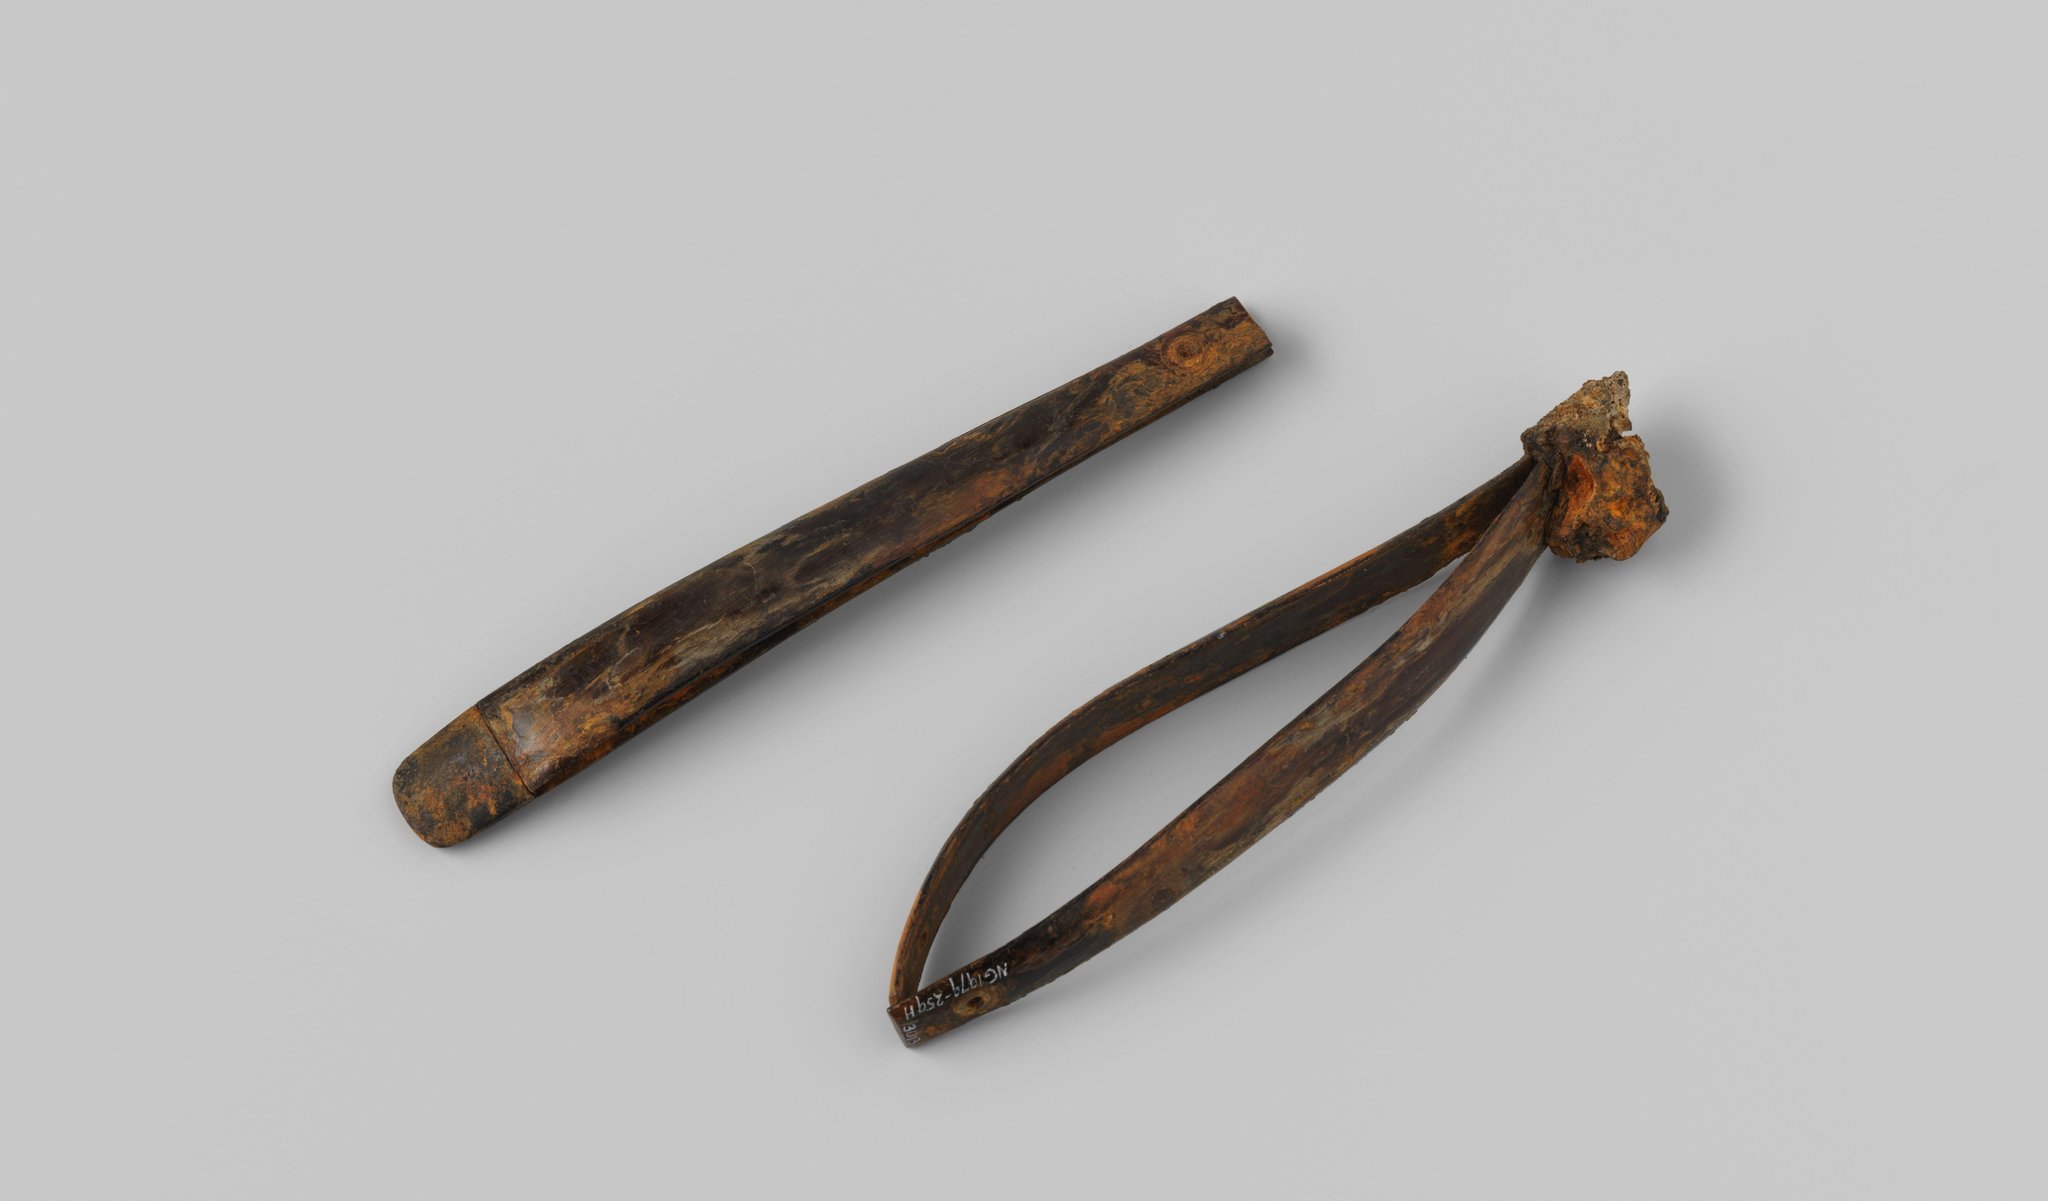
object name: scheermes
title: Razor from the wreck of the Dutch East Indiaman Hollandia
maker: Anonymous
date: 1700-1743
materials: bone, shell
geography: netherlands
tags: verenigde oostindische compagnie, hollandia (schip), annet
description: Razor, handle; each consisting of 2 oblong strips, flat, tapering, at one end joined by semicircular cap, circular hole at other end.